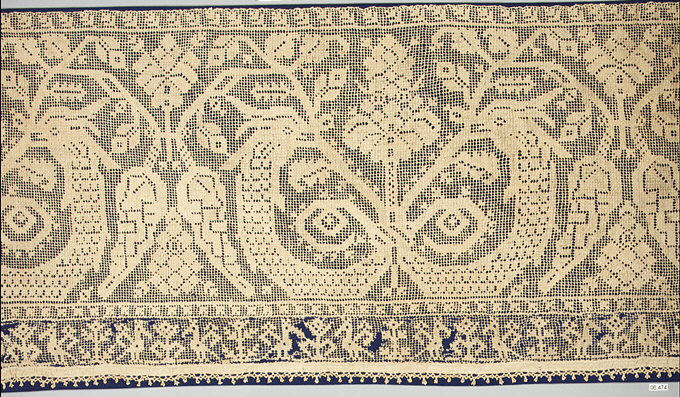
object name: cover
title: End of a cover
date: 1501-1600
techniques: embroidery